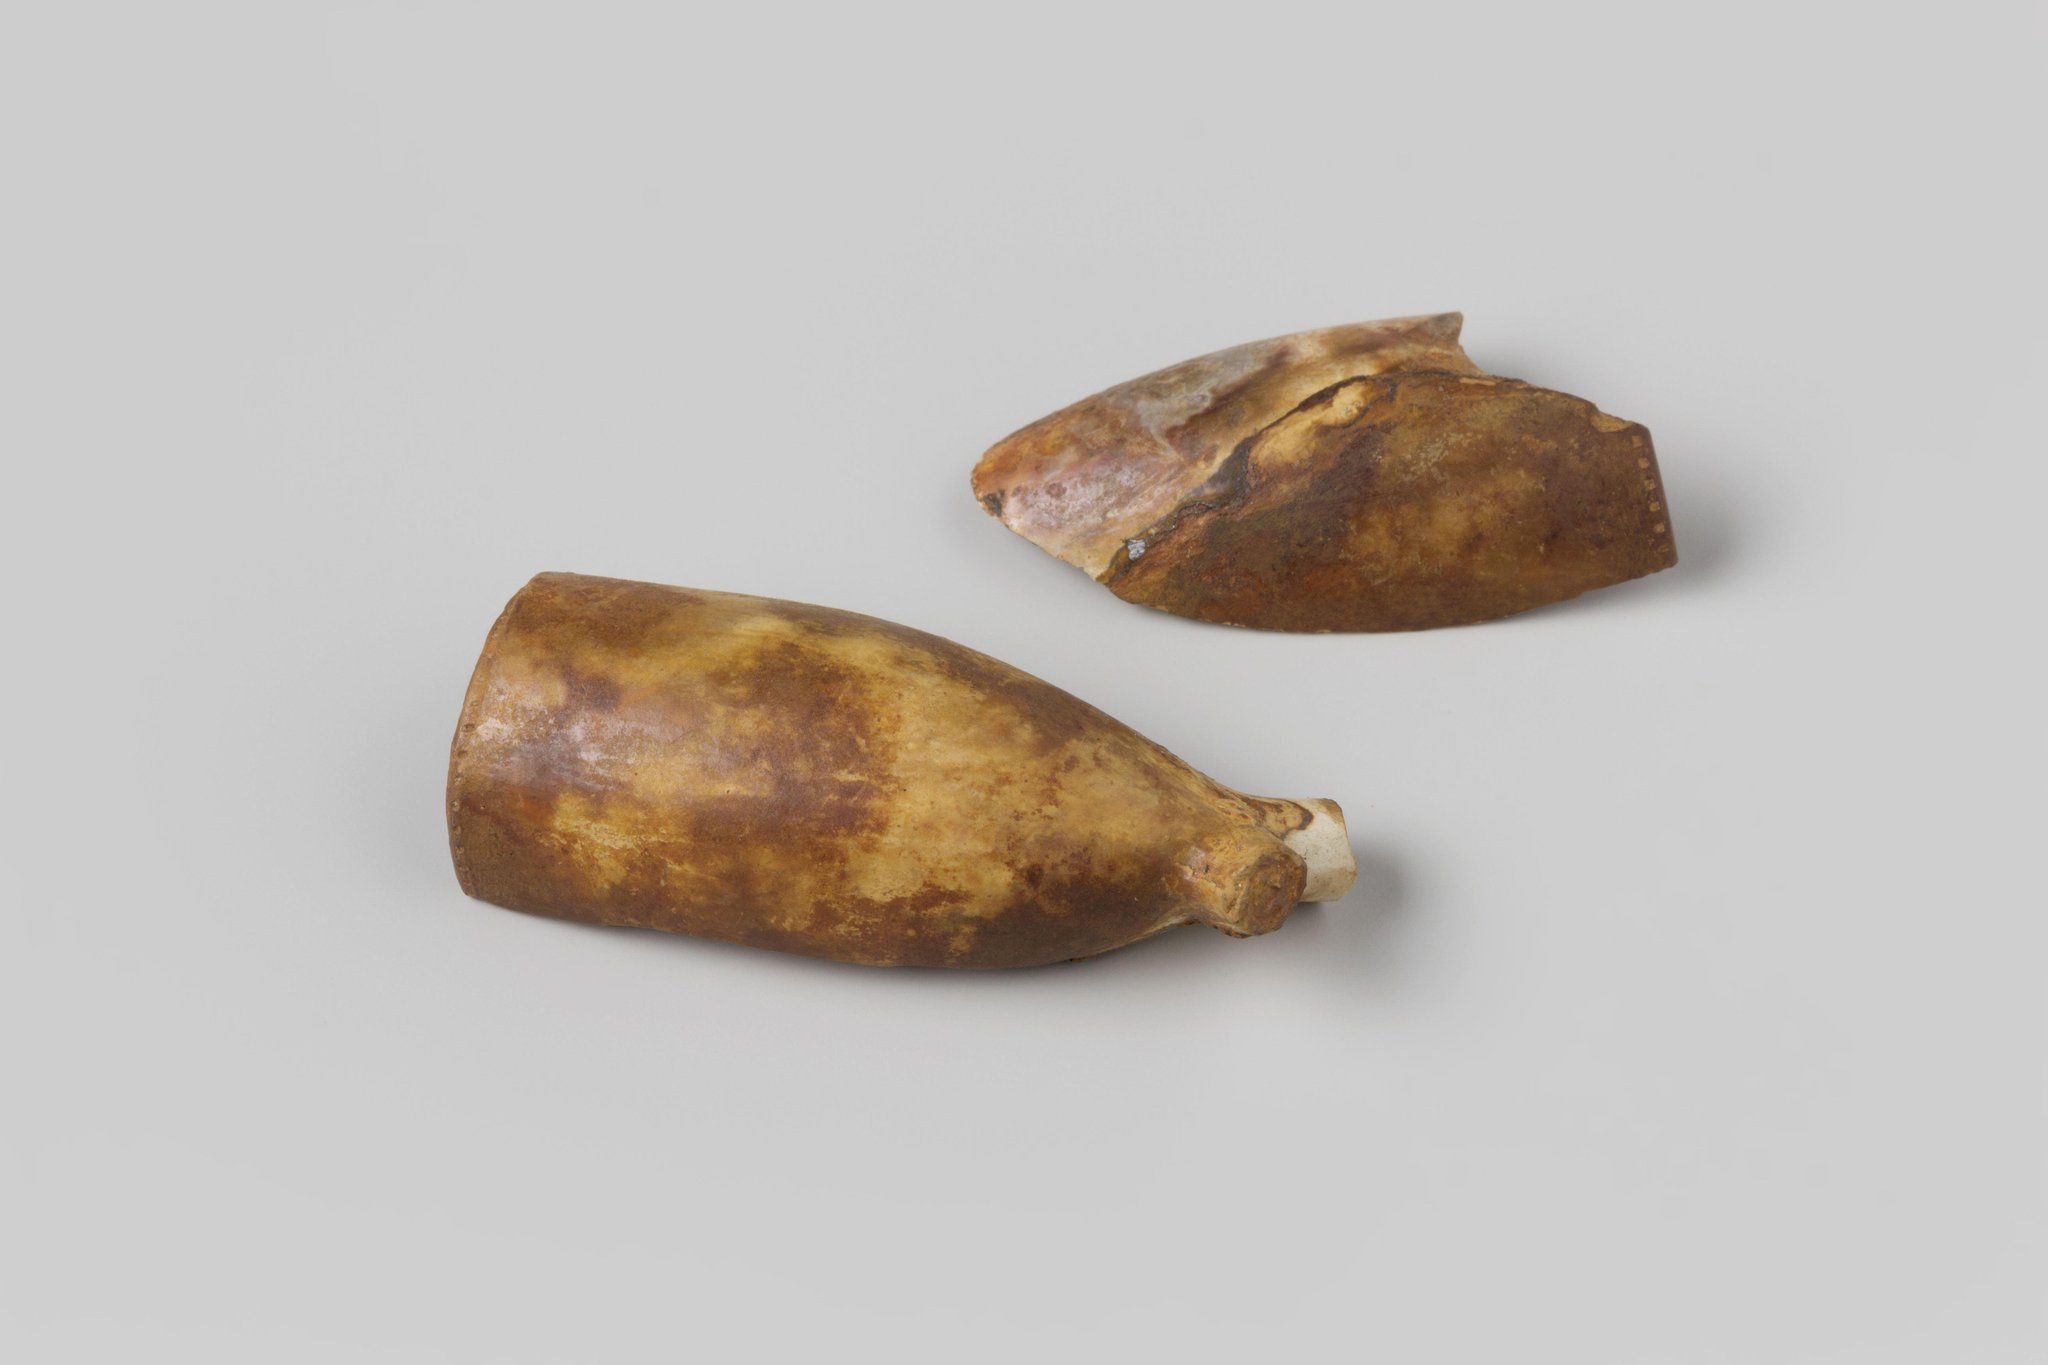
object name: pipe bowl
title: Fragmenten pijpenkop uit het wrak van de Oost-Indiëvaarder Hollandia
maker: Anonymous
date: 1700-1743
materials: clay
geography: netherlands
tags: verenigde oostindische compagnie, hollandia (schip), annet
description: Pipe, bowl, heelmark: crowned 57; fragments, 2hsm3.